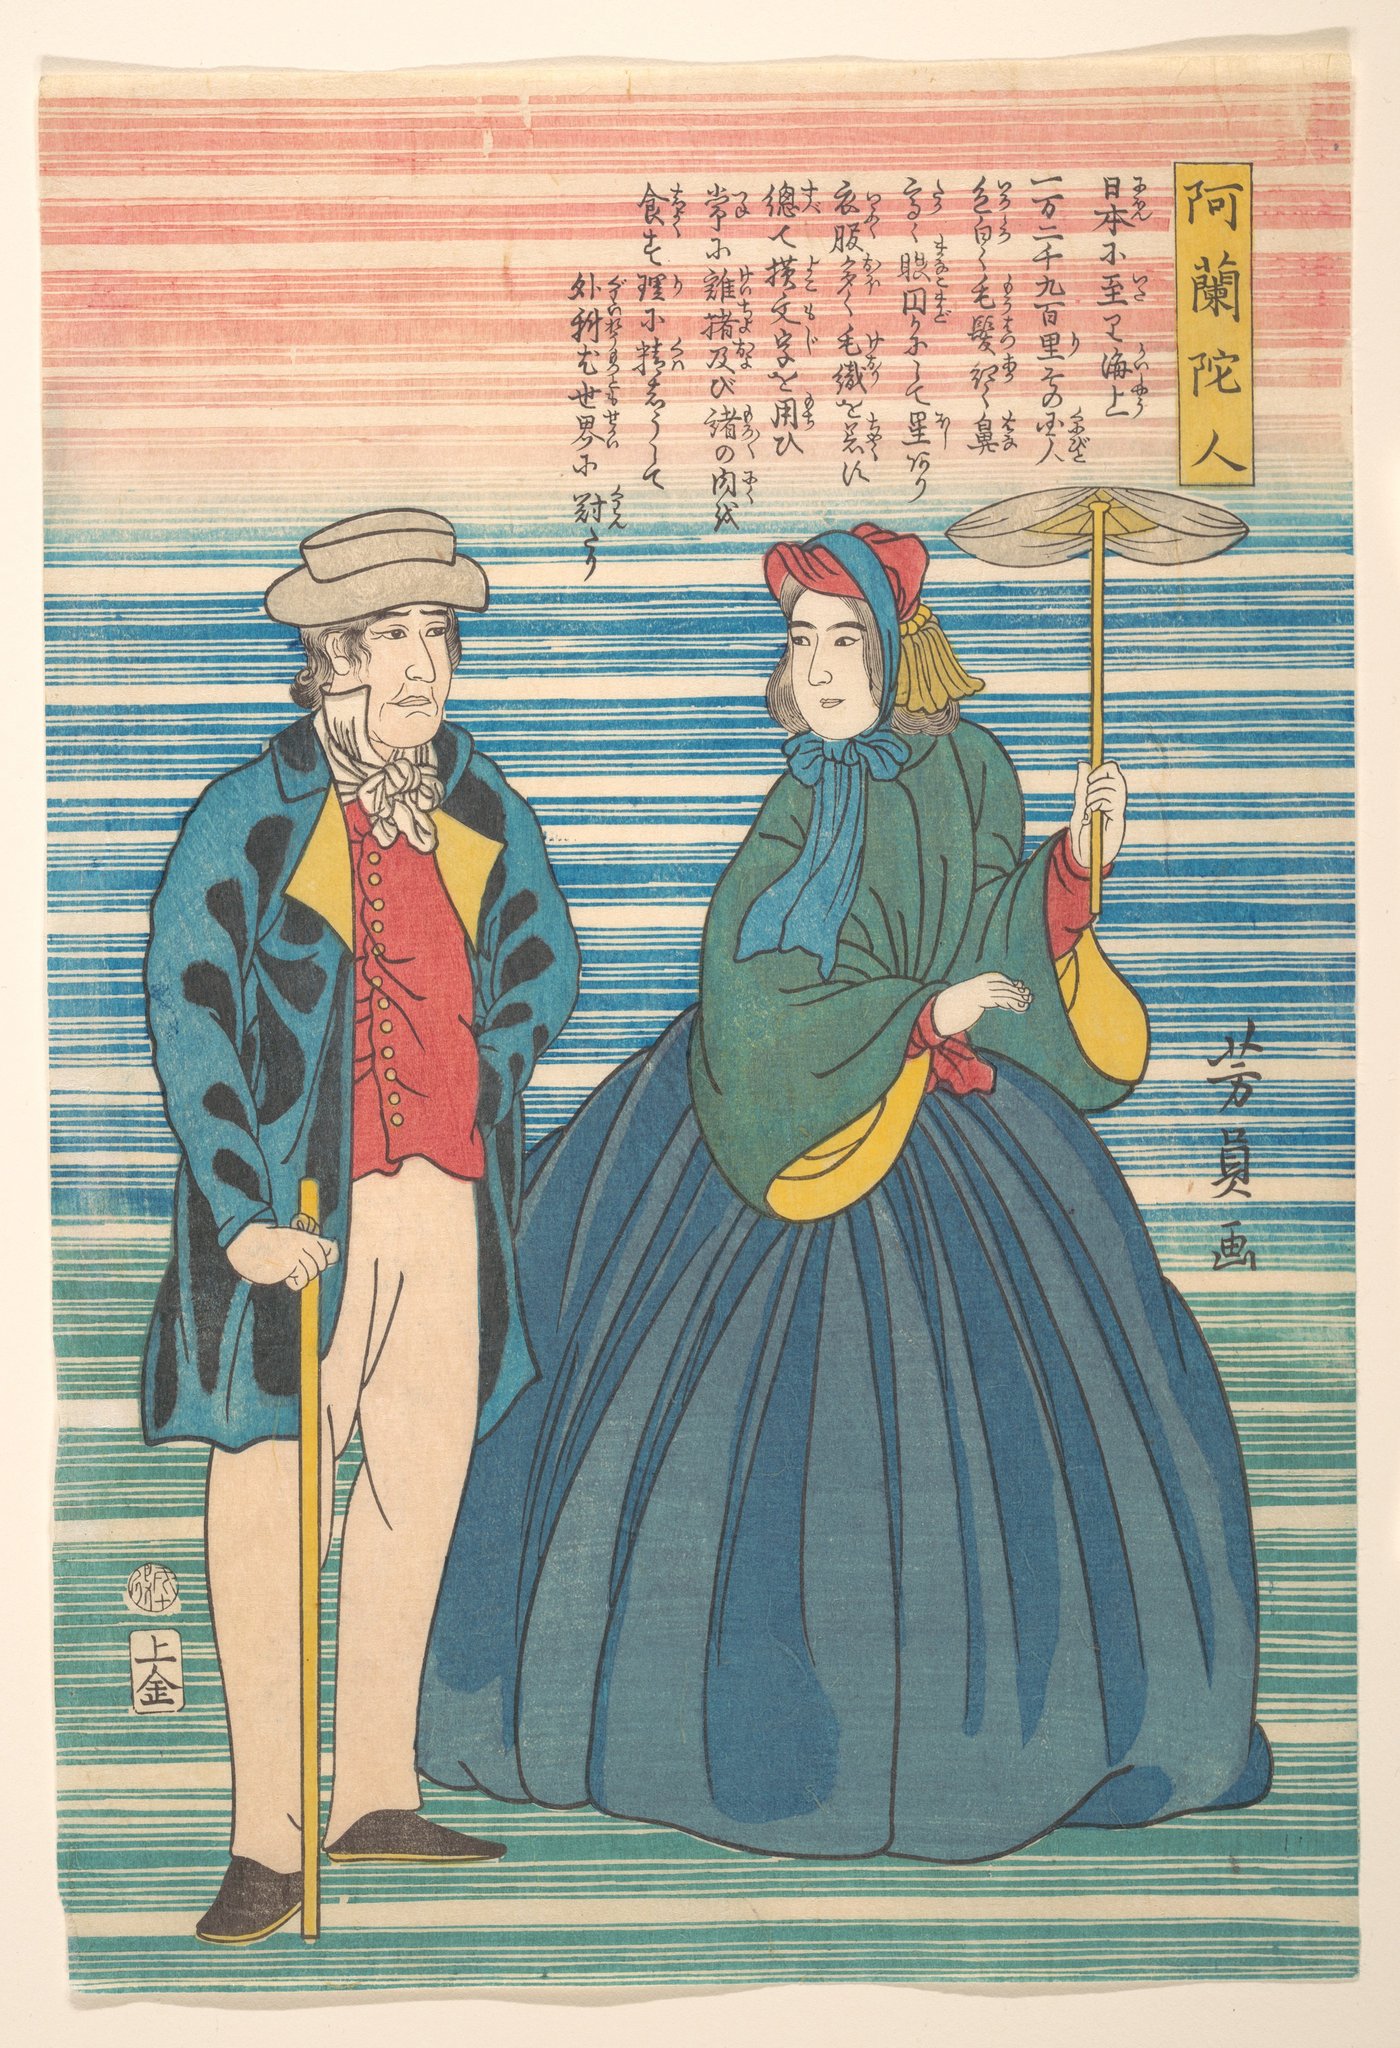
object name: print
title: Dutch Couple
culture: japanese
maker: utagawa yoshikazu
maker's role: artist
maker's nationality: japanese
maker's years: 1845-1870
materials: ink, paper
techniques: woodblock print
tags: couples